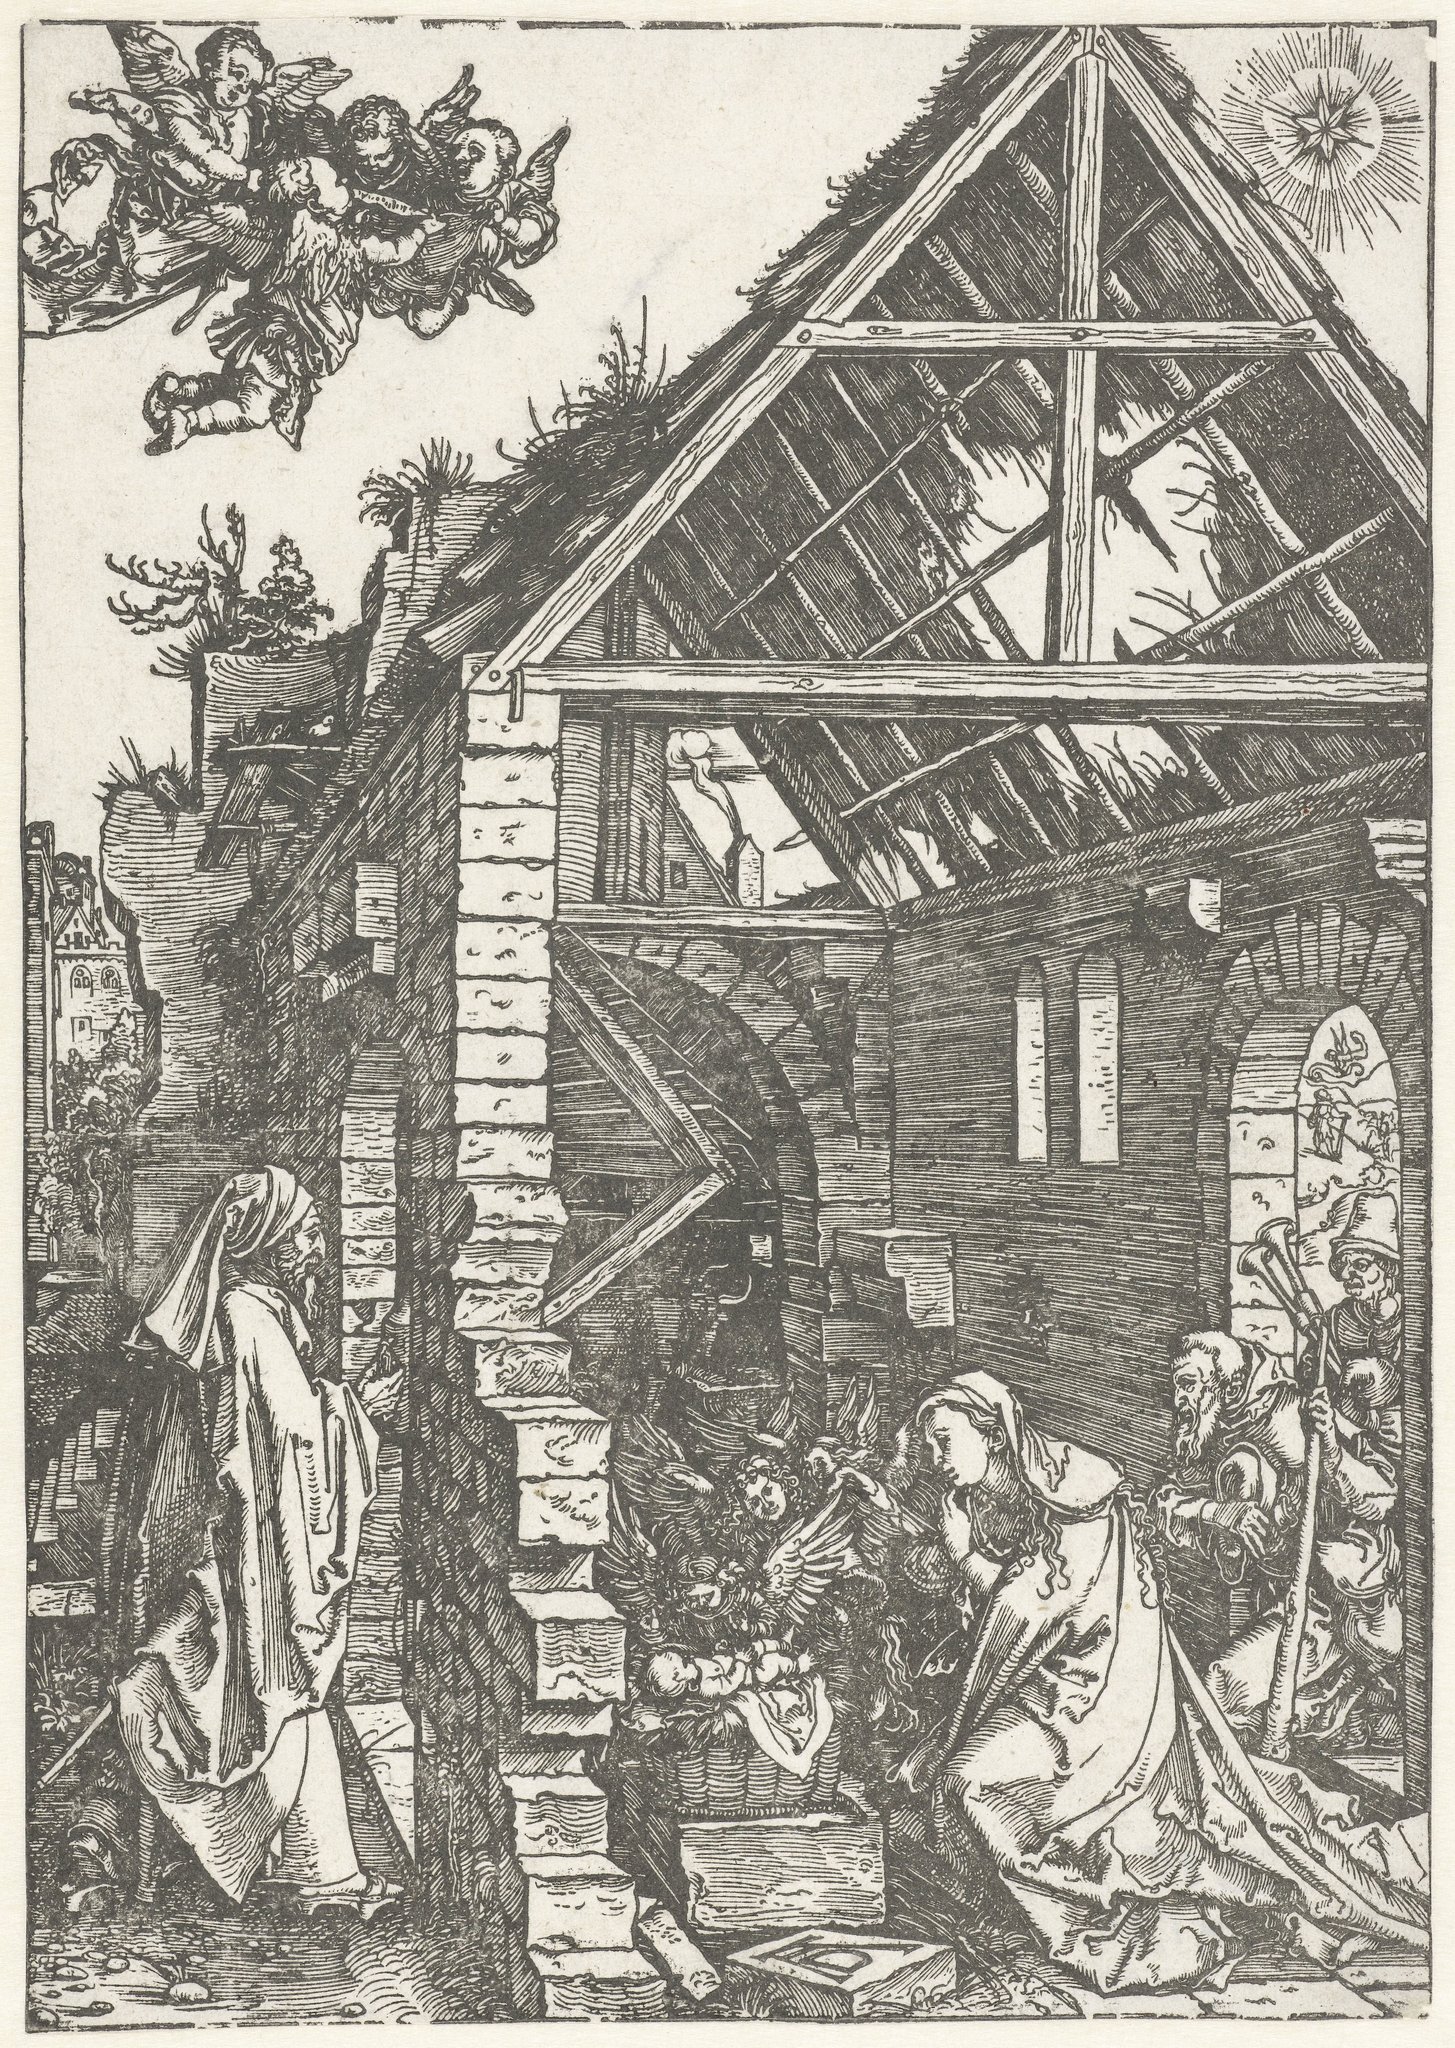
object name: print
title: Leven van Maria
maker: albrecht dürer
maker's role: draughtsman, painter, print maker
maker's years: 1471-1528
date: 1502-1503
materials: paper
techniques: woodcut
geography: nuremberg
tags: adoration of the christ-child by the shepherds; mary and joseph present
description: In een vervallen huis knielt Maria bij haar kind. Engeltjes staan naast haar. Herders komen door een deur achter haar binnen, Jozef door een deur voor haar. Deze prent is onderdeel van een serie van 20 prenten, bestaand uit een titelprent en 19 prenten met scènes uit het leven van Maria.